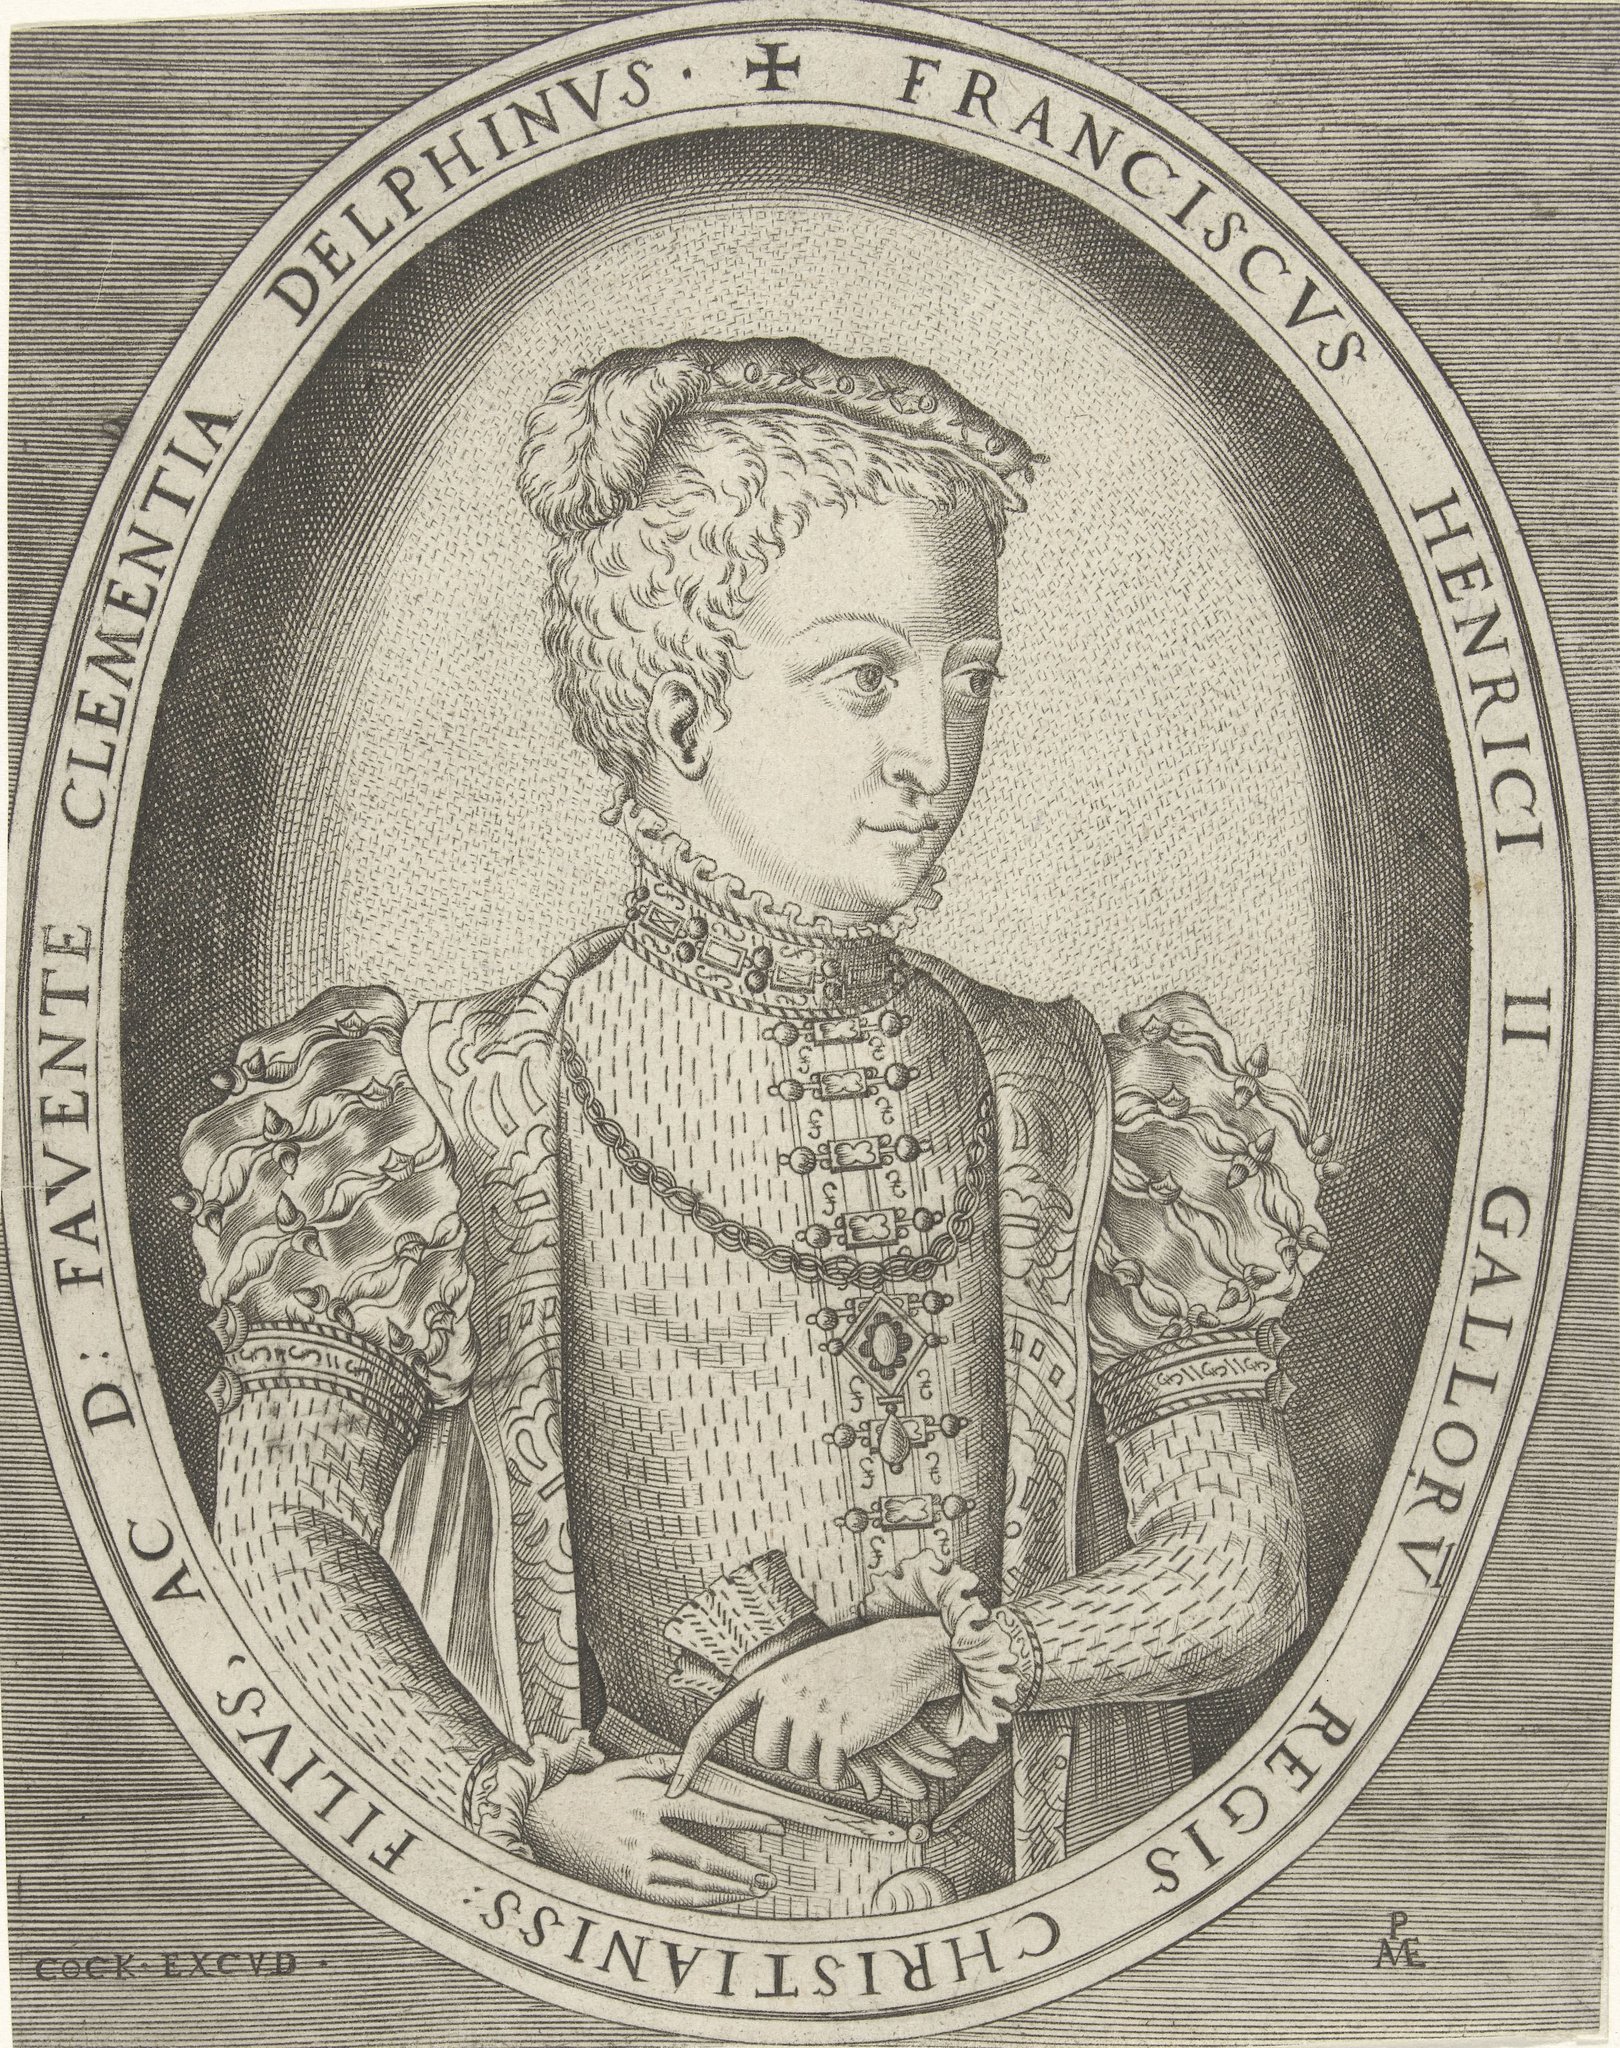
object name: print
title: Portretten van heersers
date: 1544-1560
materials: paper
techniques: engraving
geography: antwerp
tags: paris, gloves, mittens, etc.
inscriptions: collector's mark: Lugt 2228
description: Portret ten halven lijve naar rechts van Frans II, koning van Frankrijk in een ovaal met zijn naam en titel in het Latijn.